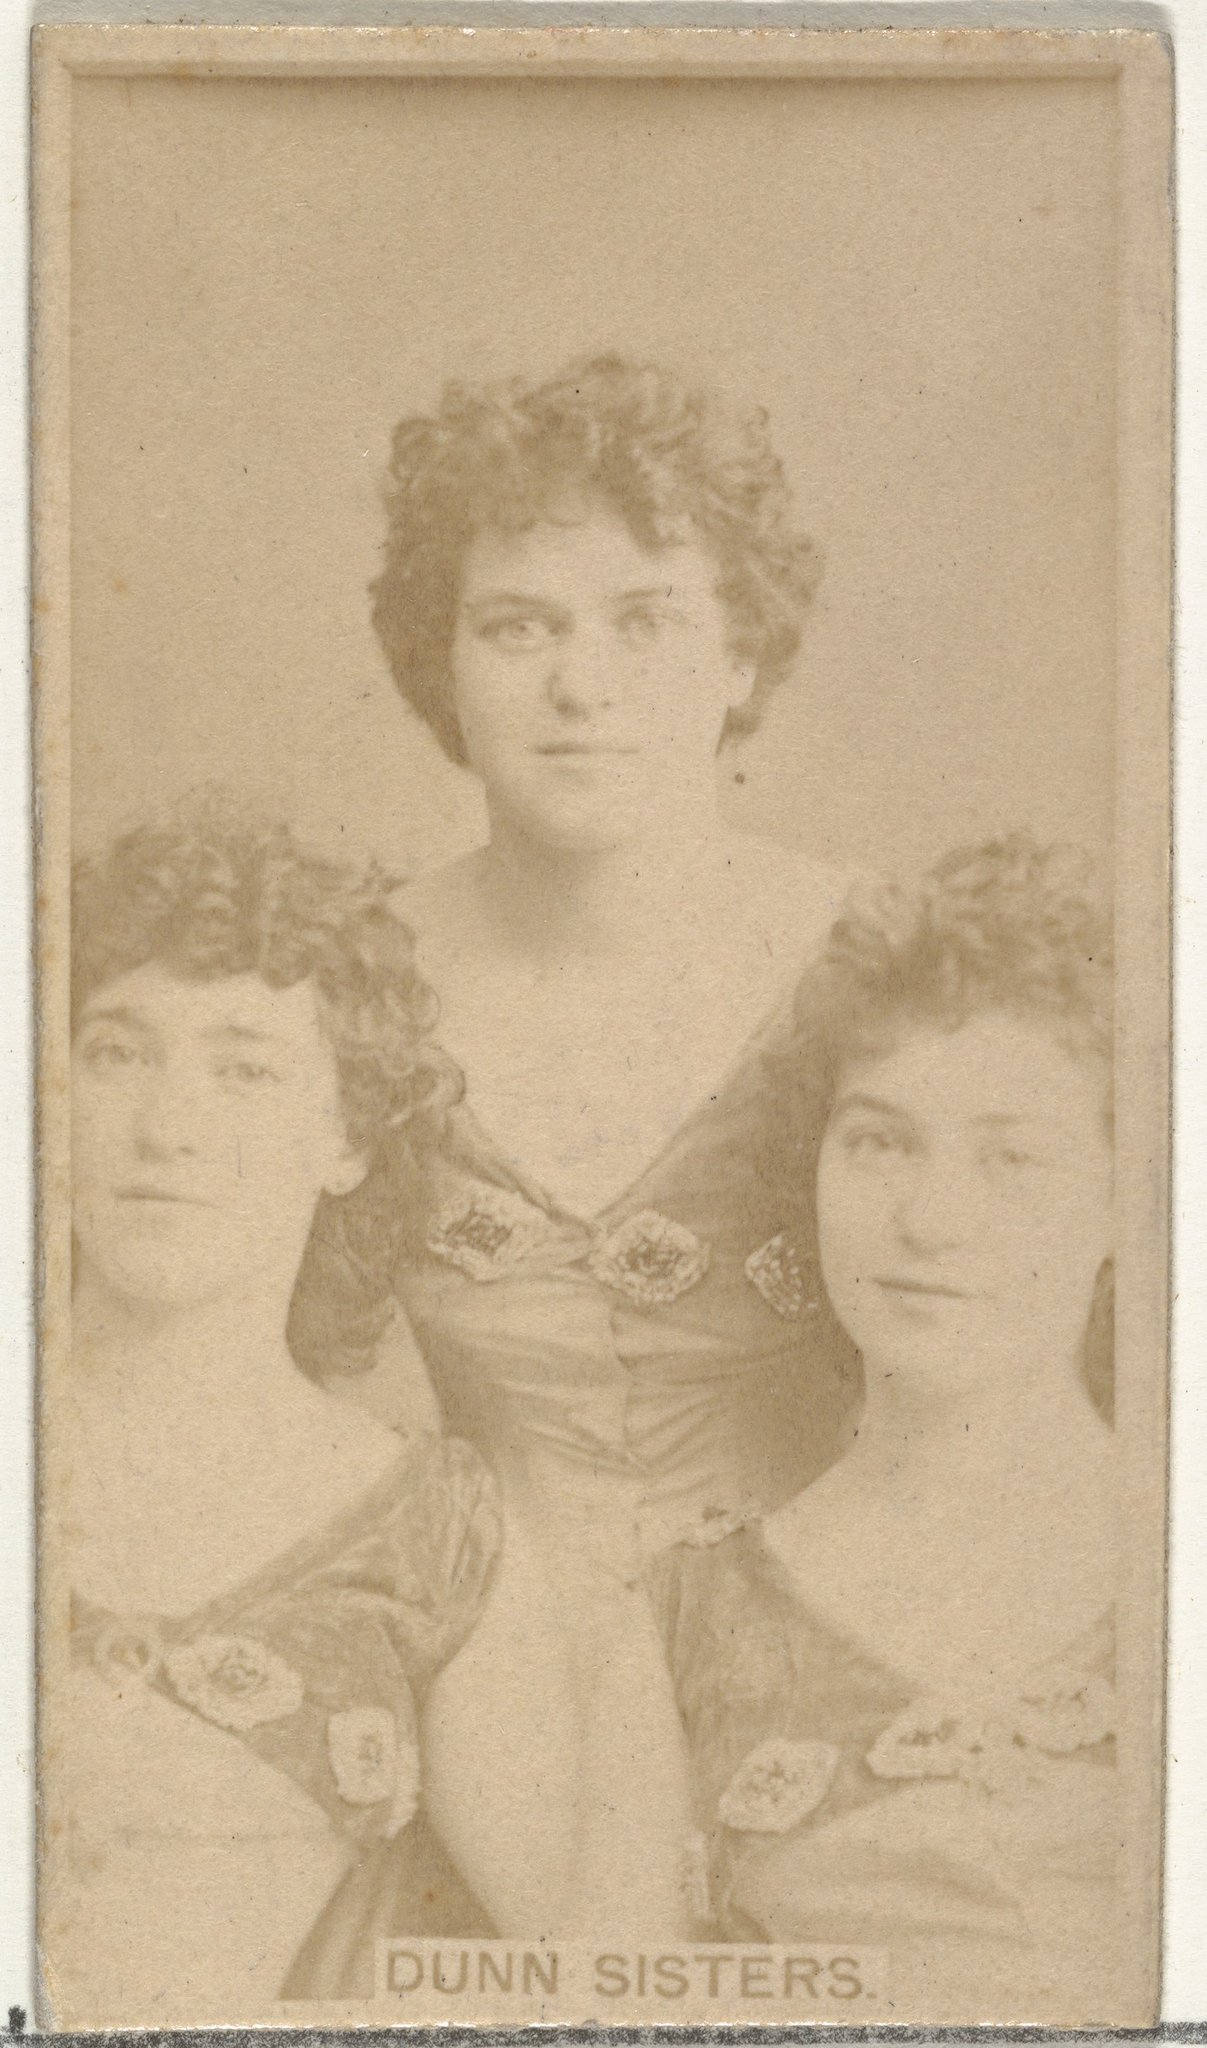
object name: photograph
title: Dunn Sisters, from the Actors and Actresses series (N145-8) issued by Duke Sons & Co. to promote Duke Cigarettes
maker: w. duke, sons & co.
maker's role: publisher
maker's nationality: american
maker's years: 1870-1920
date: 1891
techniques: albumen silver print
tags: portraits,women,actresses